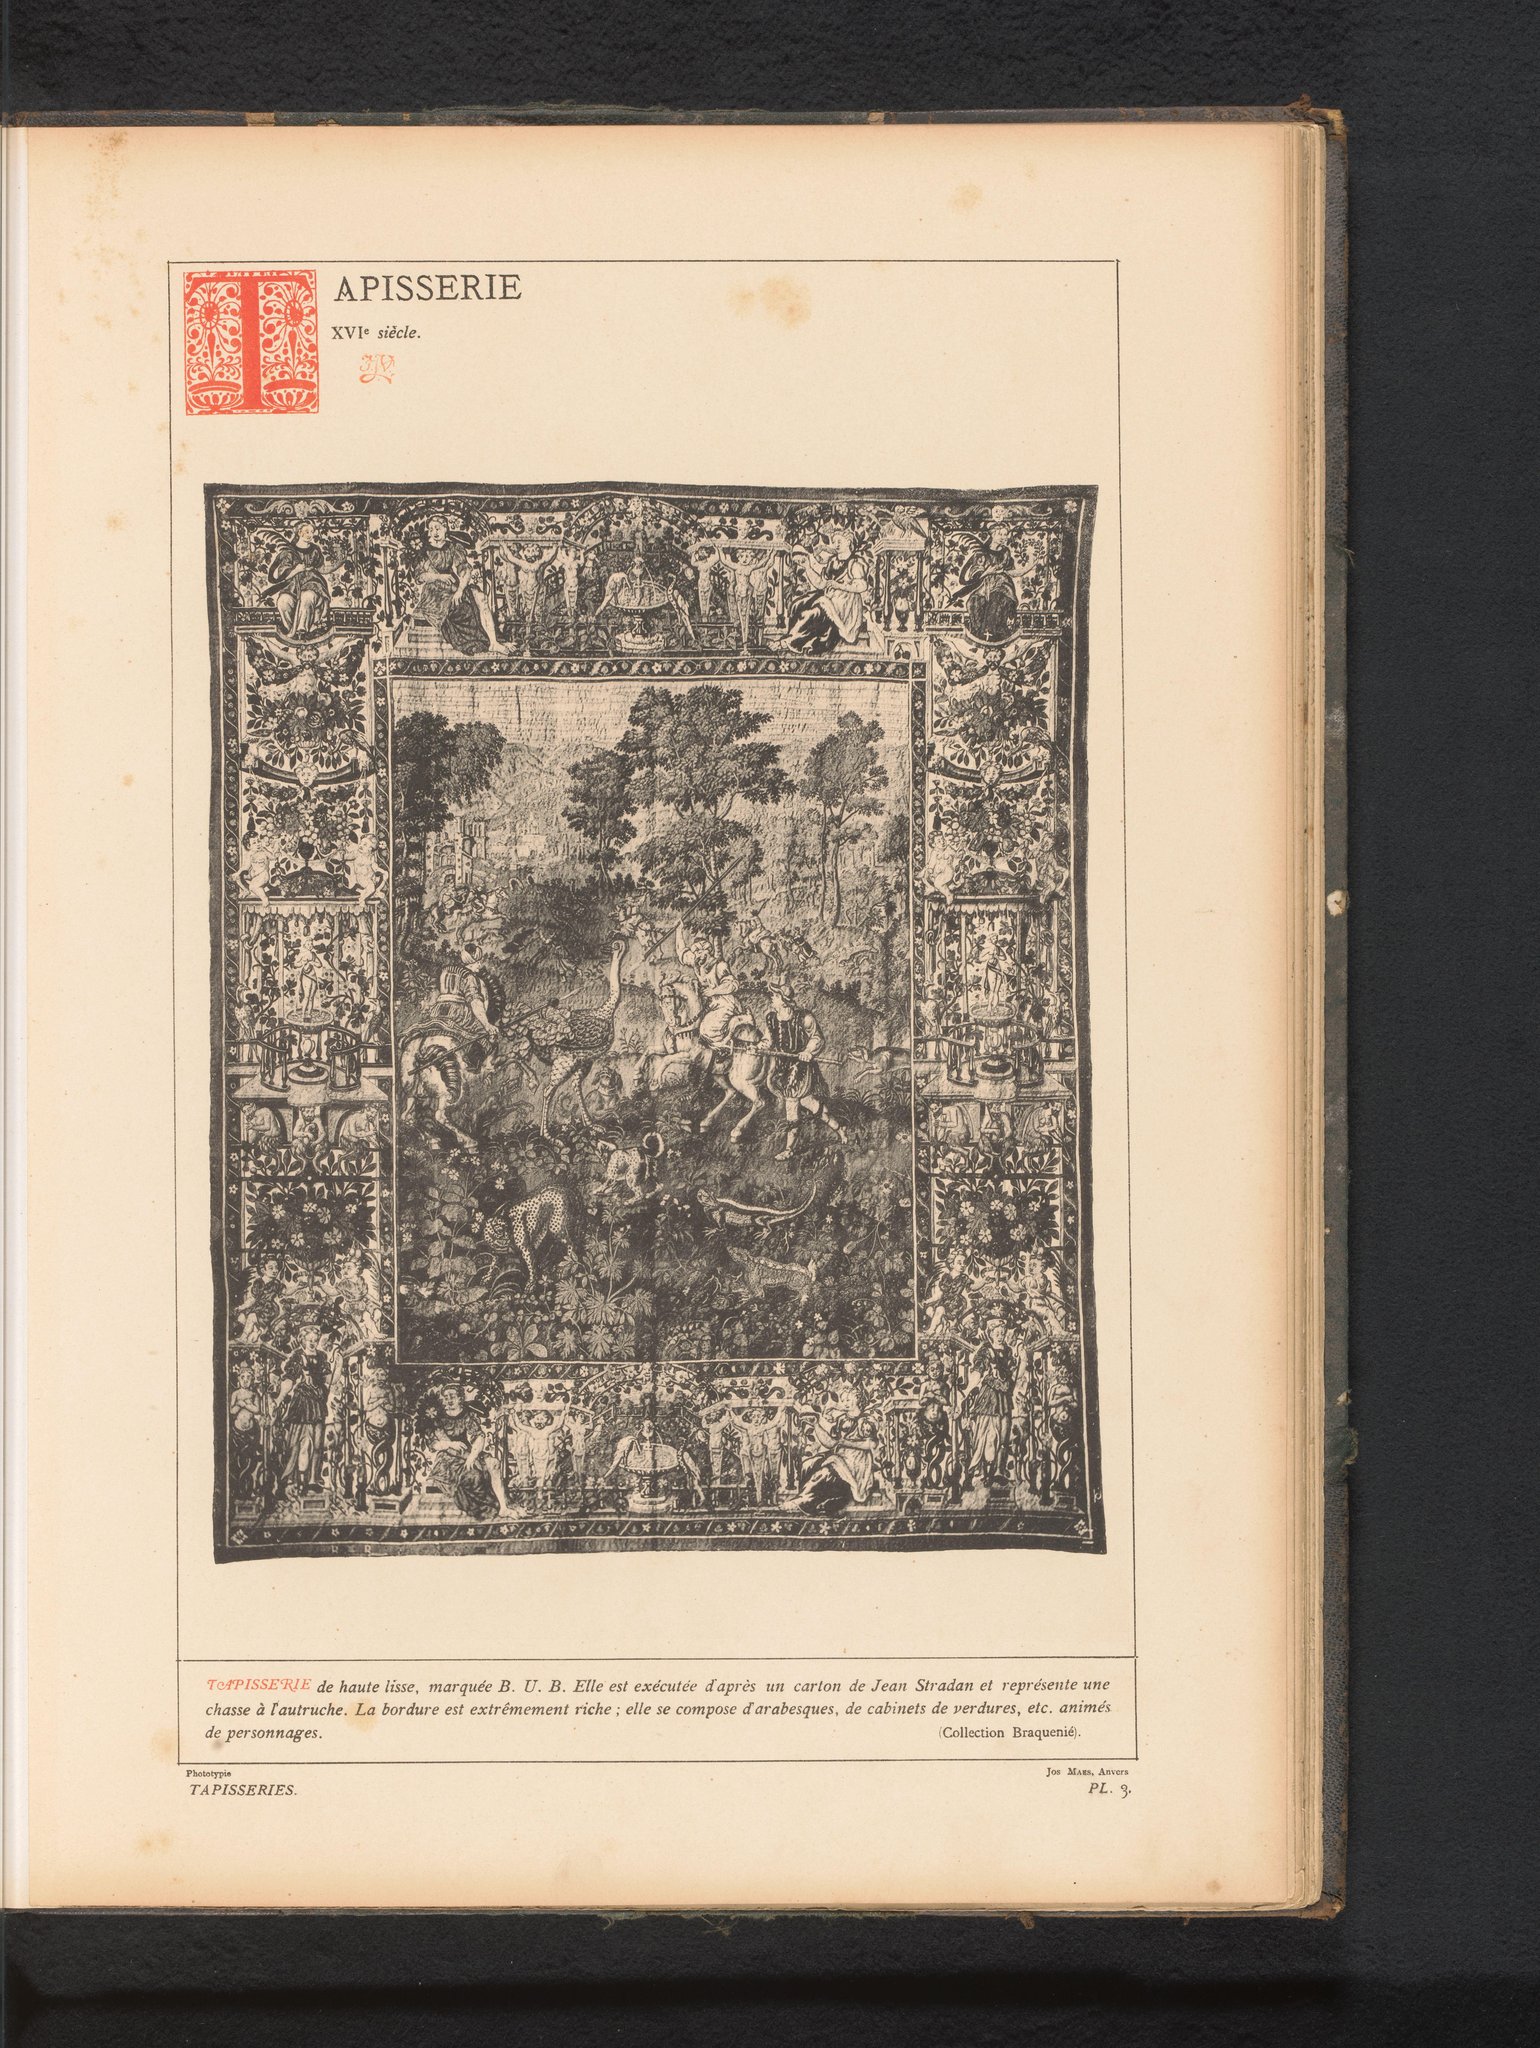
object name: photomechanical print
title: Tapisserie, XVIe siècle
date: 1882-1887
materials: paper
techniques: photograph, photolithography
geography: antwerp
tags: ornament ~ arabesque, tapestry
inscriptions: monogram: ‘JJvY’, inscription: ‘TAPISSERIES. - PL. 3.’, inscription: ‘TAPISSERIE de haute (...)’